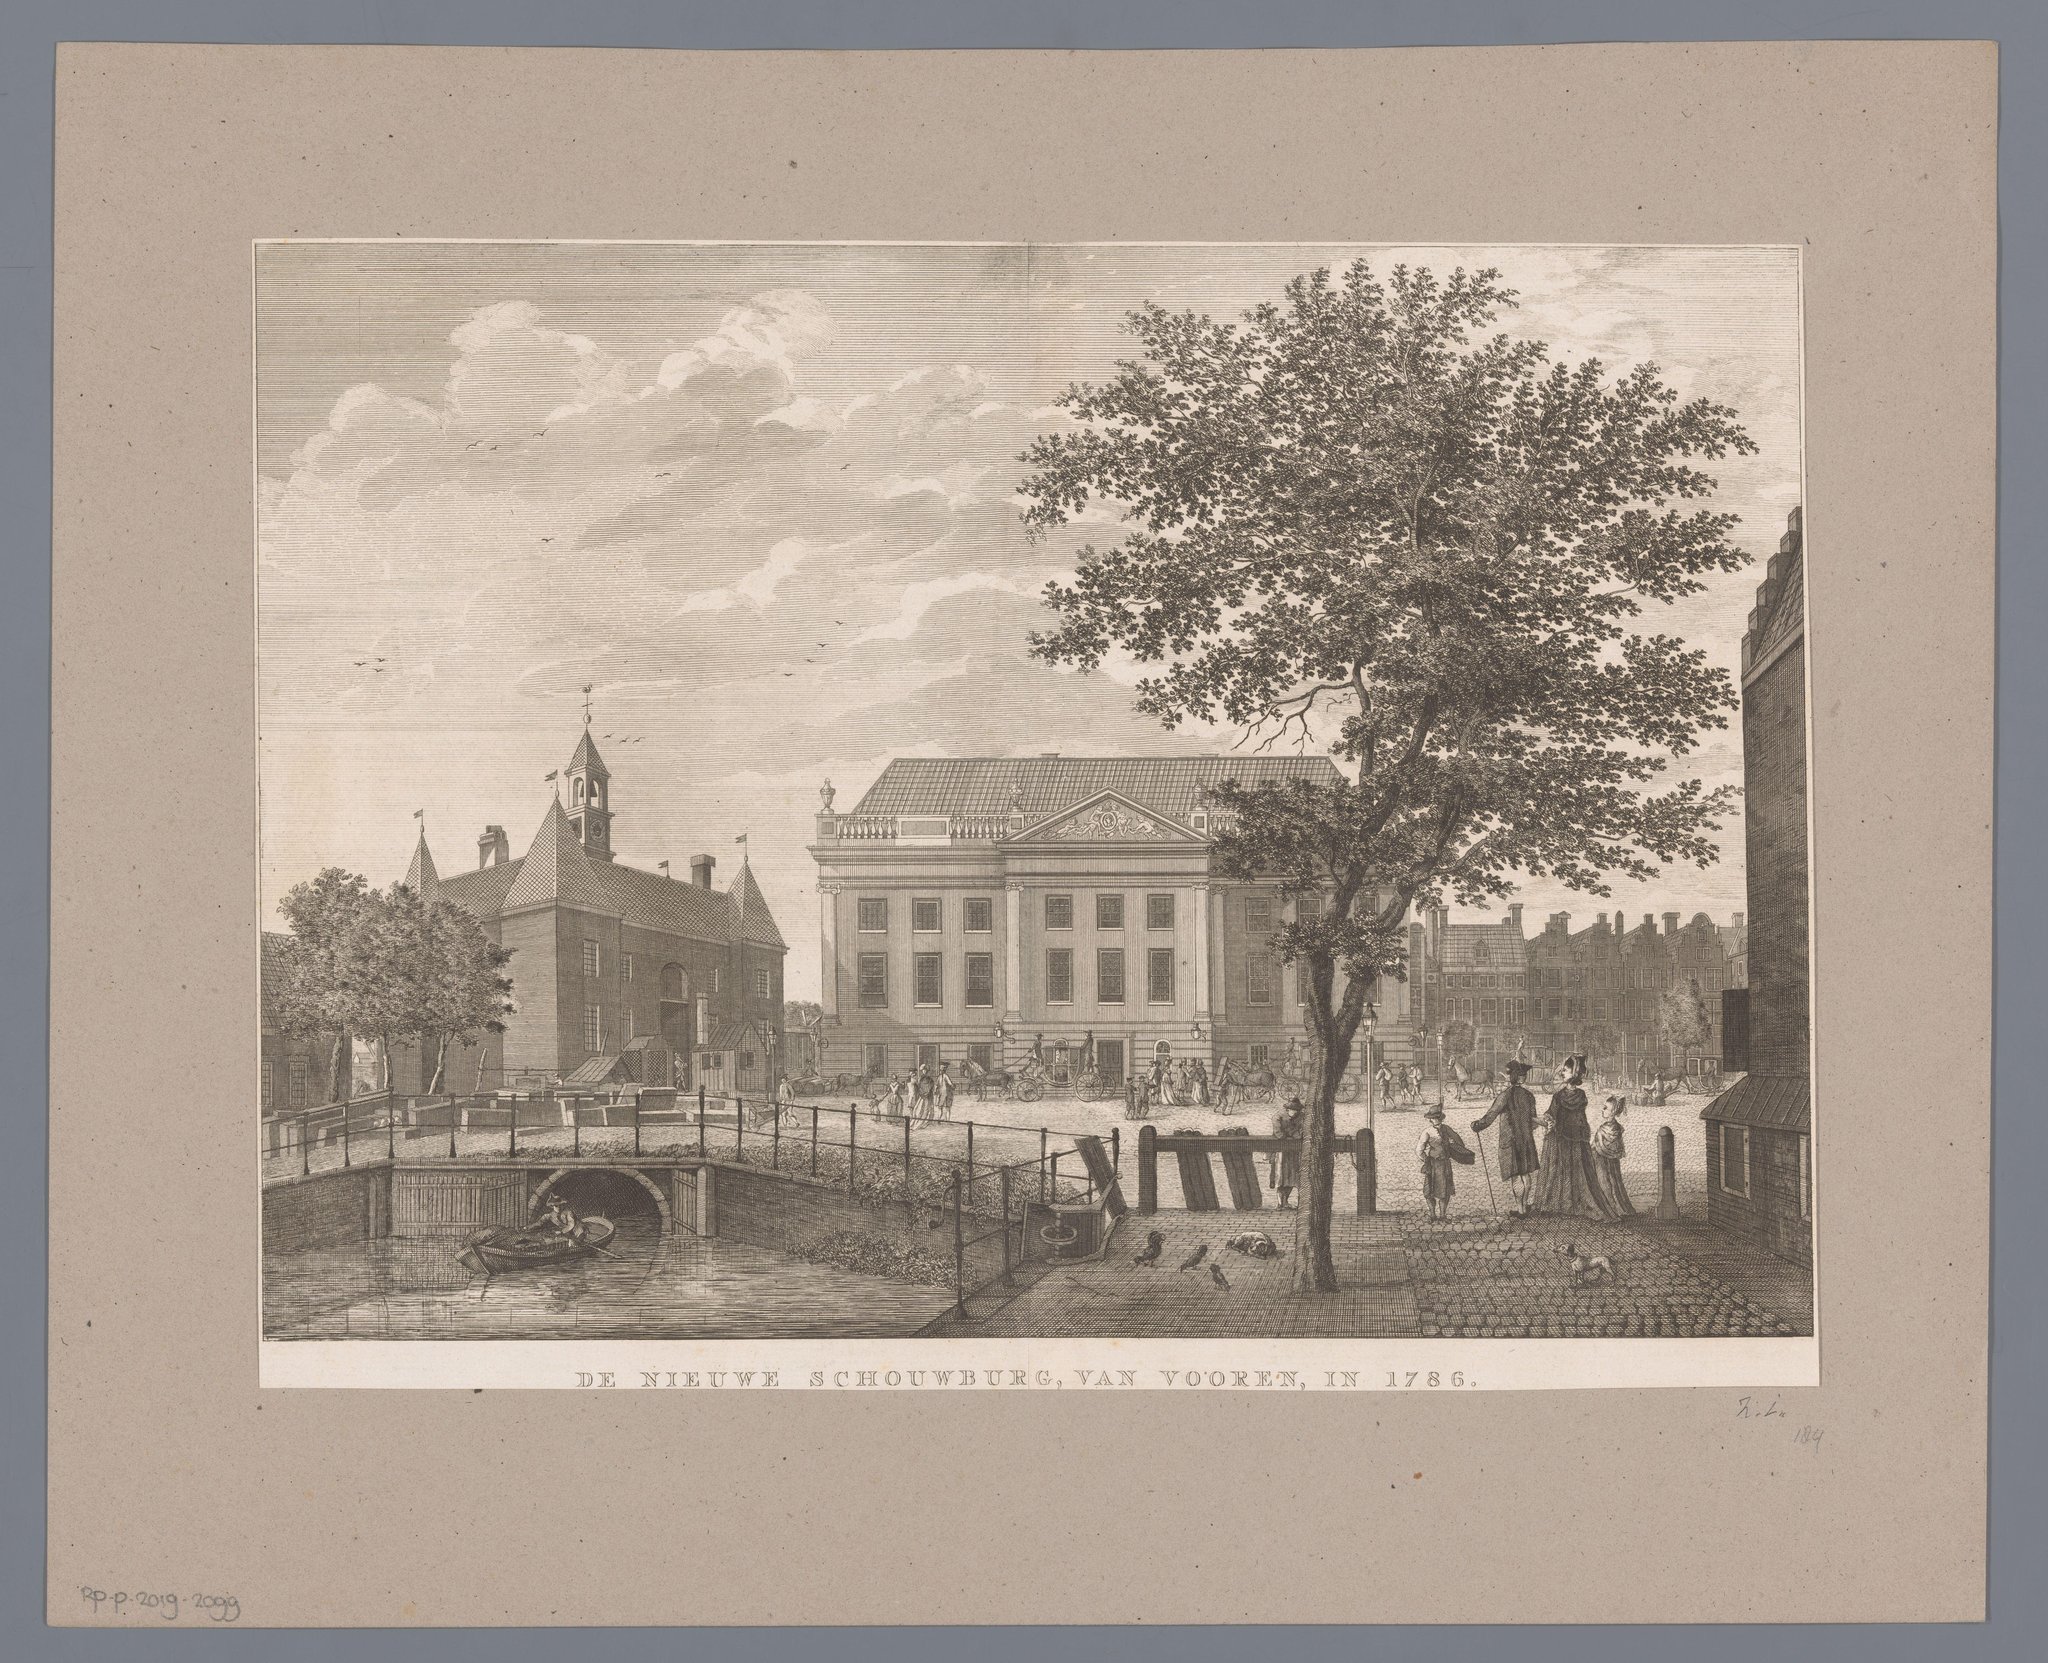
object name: print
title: Gezicht op de eerste schouwburg aan het Leidseplein in Amsterdam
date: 1789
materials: paper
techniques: engraving, etching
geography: amsterdam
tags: concert hall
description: Prent uit: Stijl, Simon. Amsterdam in zyne geschiedenissen, voorregten, koophandel (...). Amsterdam: Petrus Conradi, Harlingen: Volkert van der Plaats, 1789, dl. 4, na p. 284.